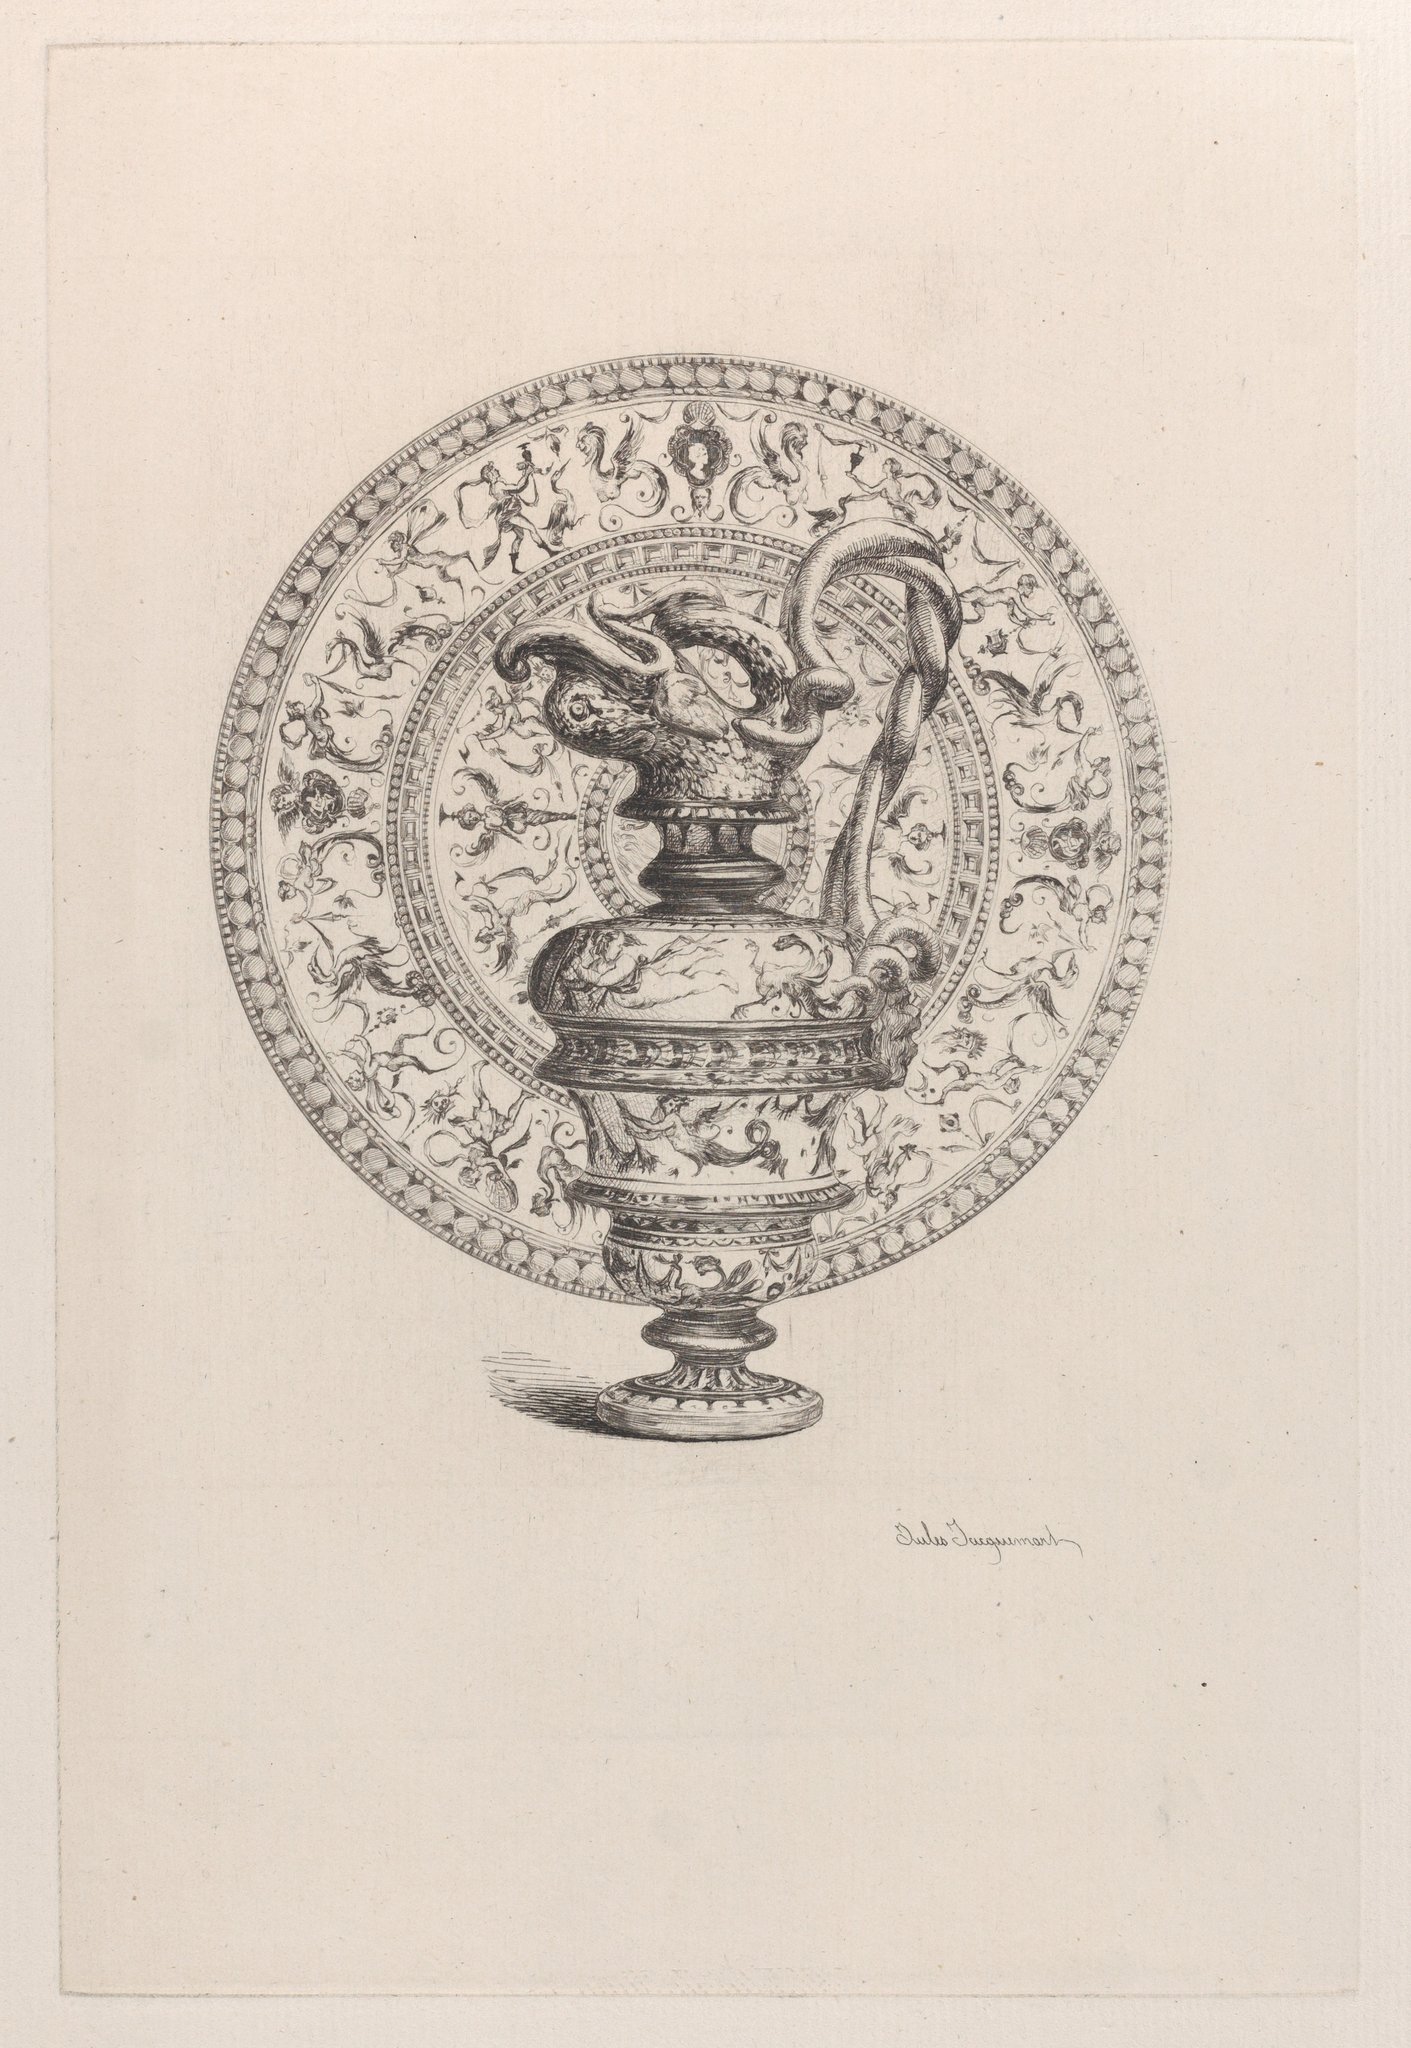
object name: print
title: Ewer and Basin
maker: jules-ferdinand jacquemart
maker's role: artist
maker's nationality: french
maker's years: 1837-1880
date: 1862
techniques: etching